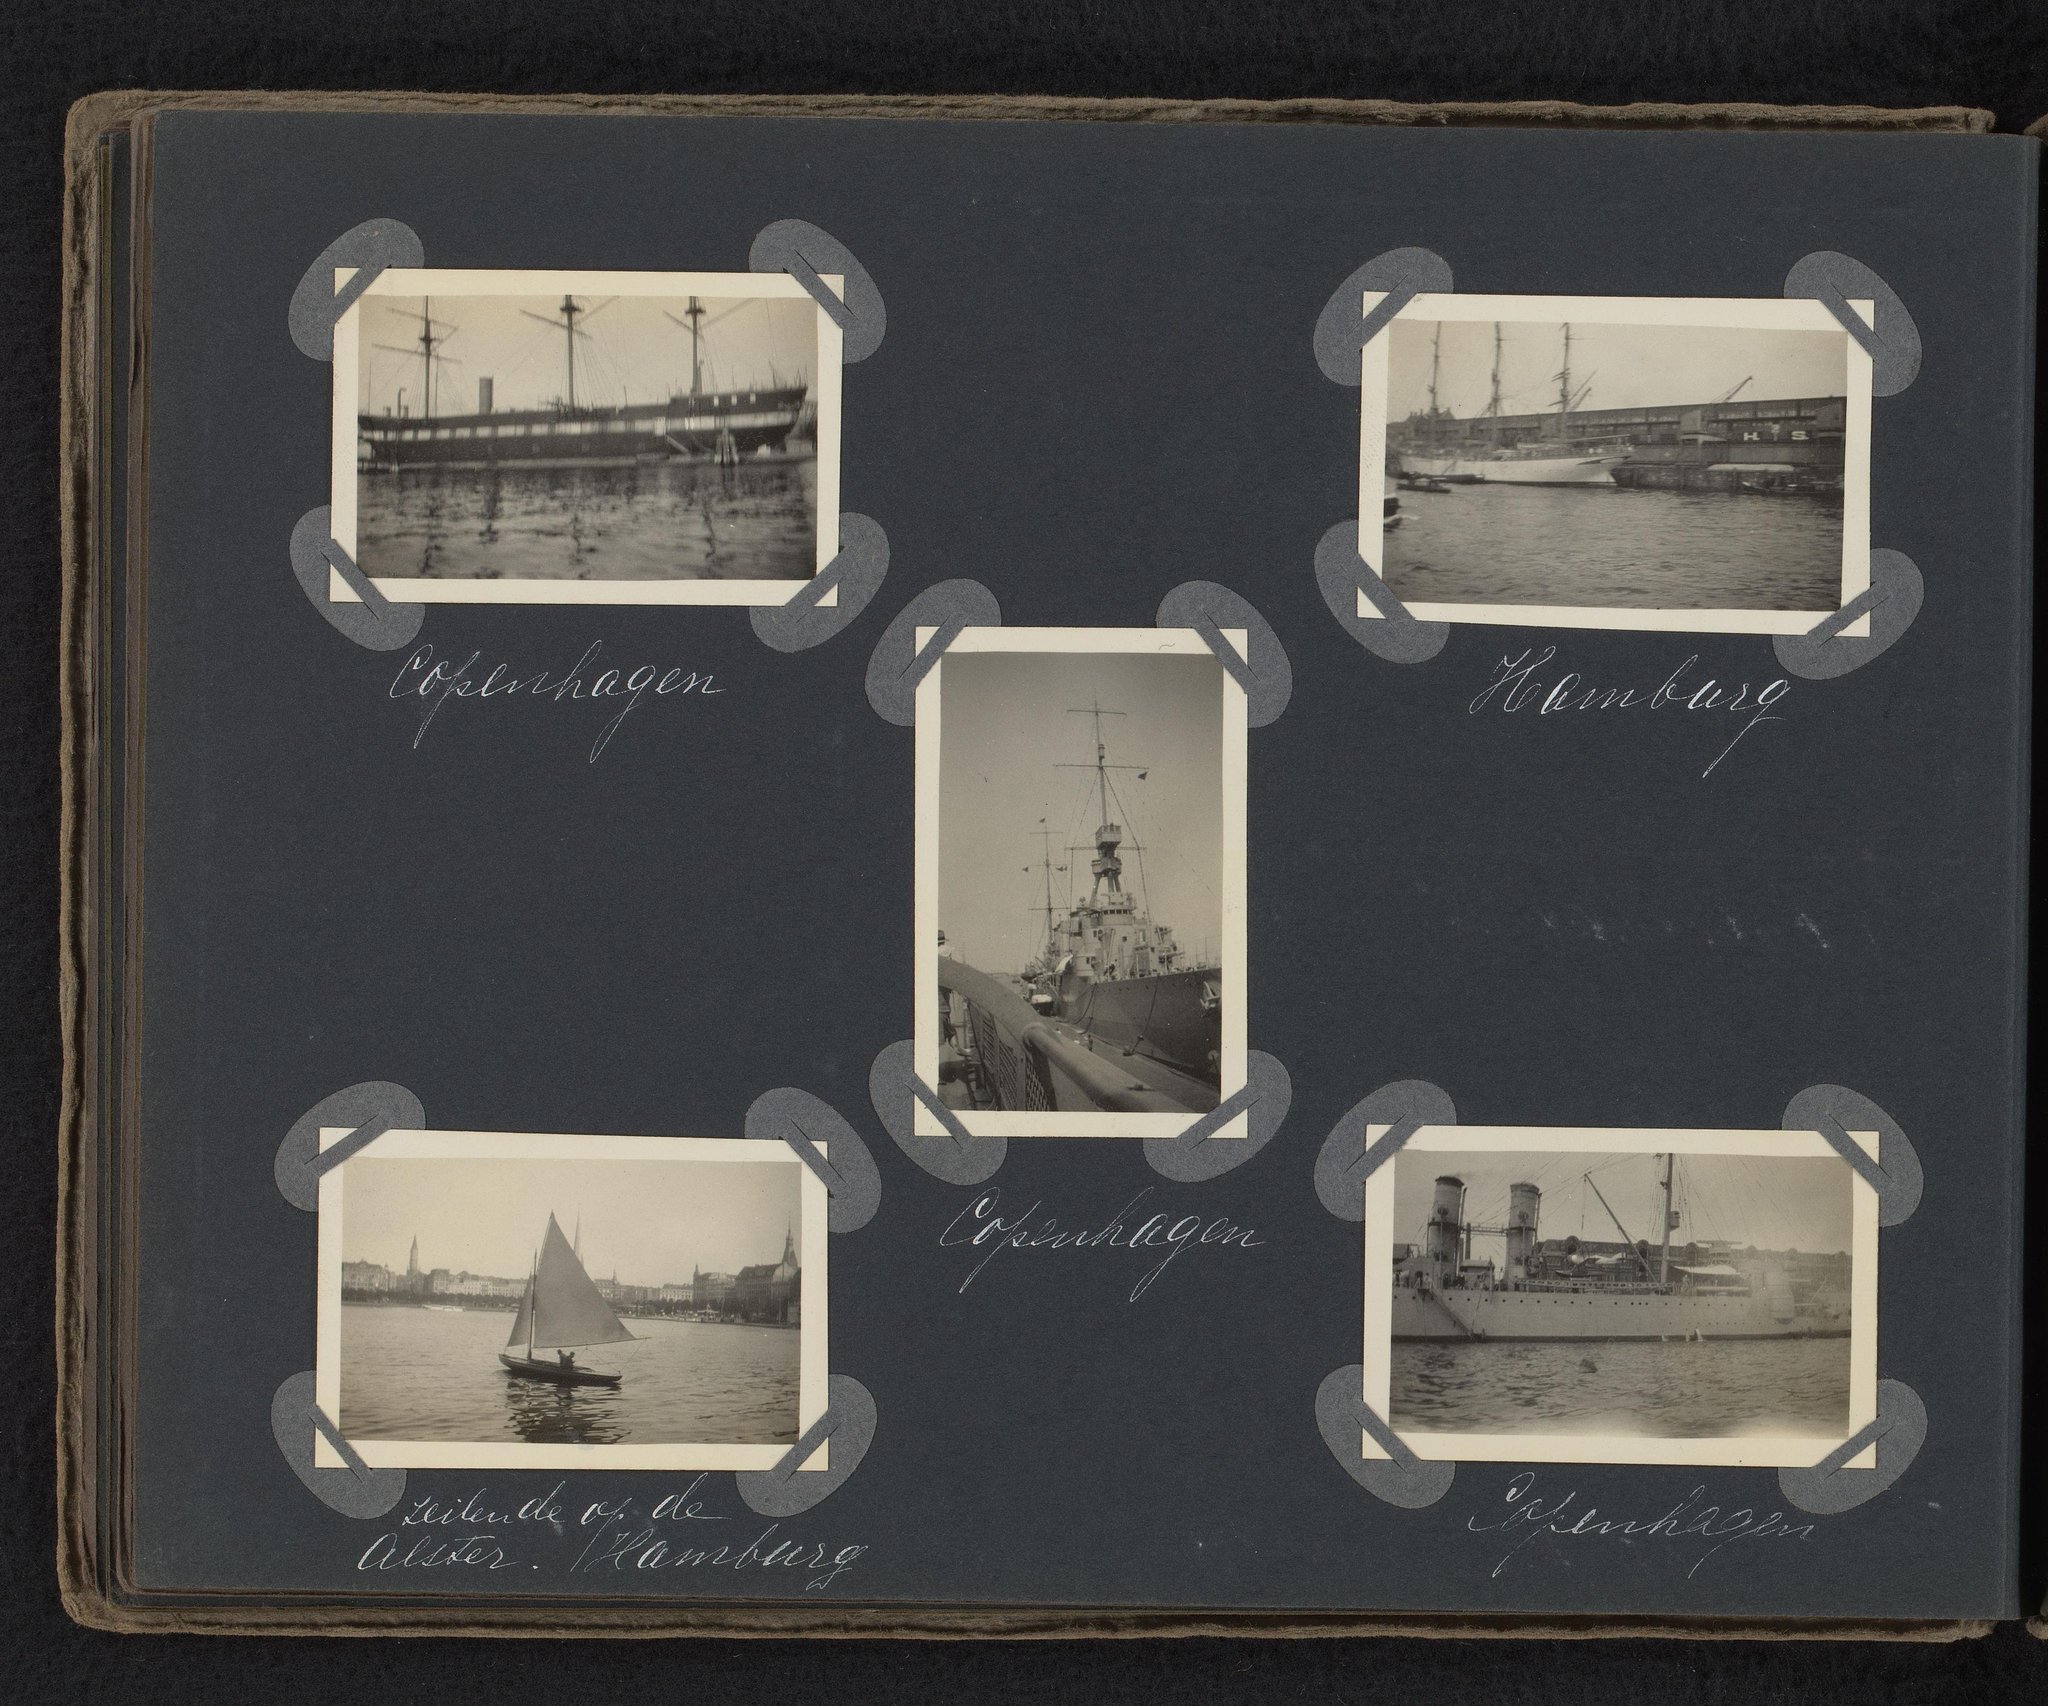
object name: photograph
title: Vijf foto's uit de havens van Kopenhagen en Hamburg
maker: frank willem van den berg (1912-1998)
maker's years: 1912-1998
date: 1927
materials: paper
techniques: gelatin silver print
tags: harbour, copenhagen (city)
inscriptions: inscription: ‘Hamburg’, inscription: ‘Zeilende op de/ Alster, Hamburg.’, inscription: ‘Copenhagen’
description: Deze foto's maken deel uit van een album.